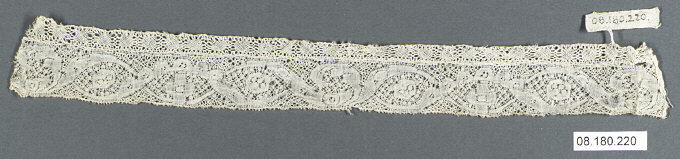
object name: piece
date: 1701-1800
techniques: lace